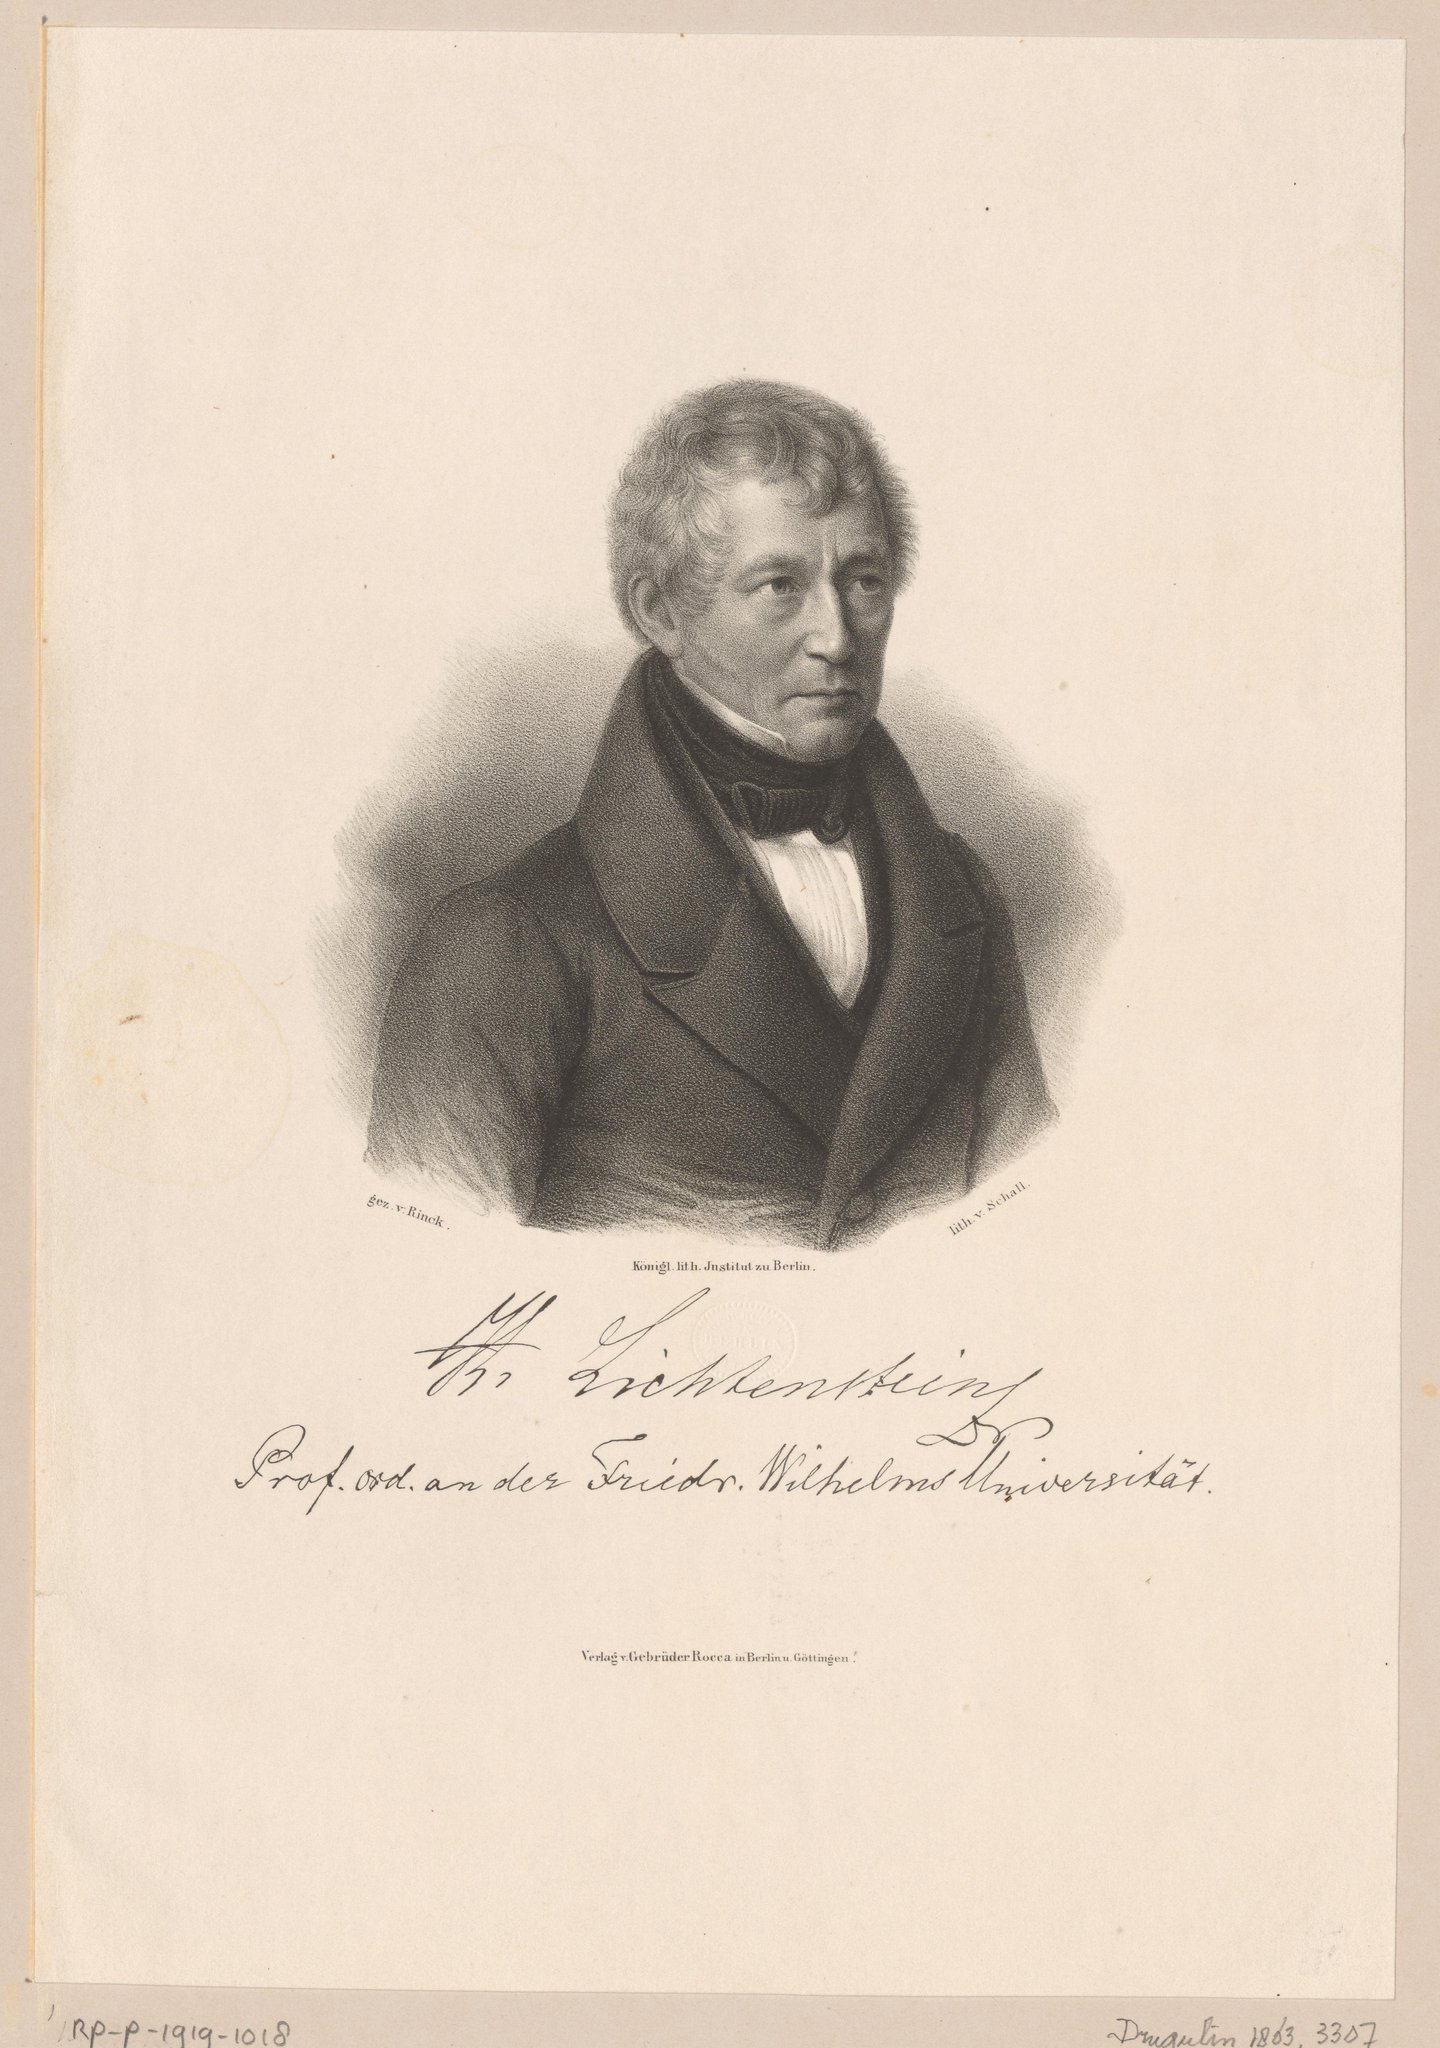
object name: print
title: Portret van Martin Hinrich Lichtenstein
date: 1830-1861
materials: paper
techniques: lithograph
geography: berlin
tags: zoology (+ portrait of scholar, scientist), historical persons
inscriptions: collector's mark: Lugt 2228, check stamp: Lugt 5514